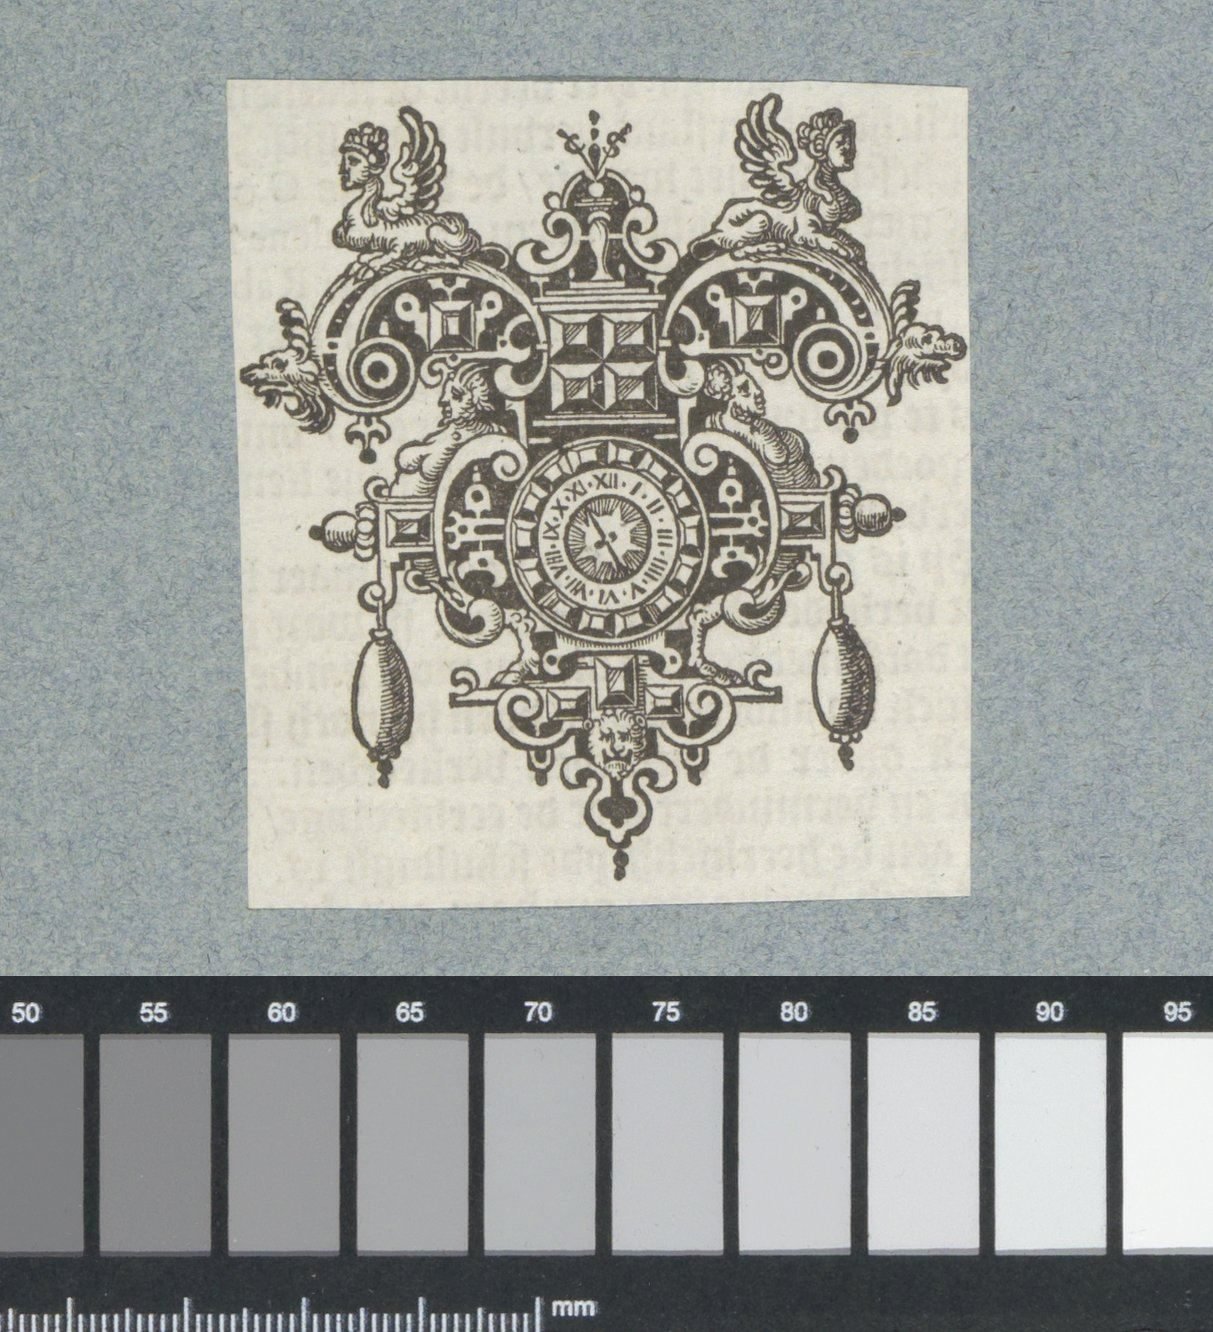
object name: ornament print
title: Ornament met sfinxen en klok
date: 1597-1667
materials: paper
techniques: letterpress printing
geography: amsterdam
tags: ornamental decoration ~ printed matter, book, clock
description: Decoratief ornament met bovenaan twee sfinxen en in het midden een klok met Romeinse nummers. De prent maakt deel uit van een album.